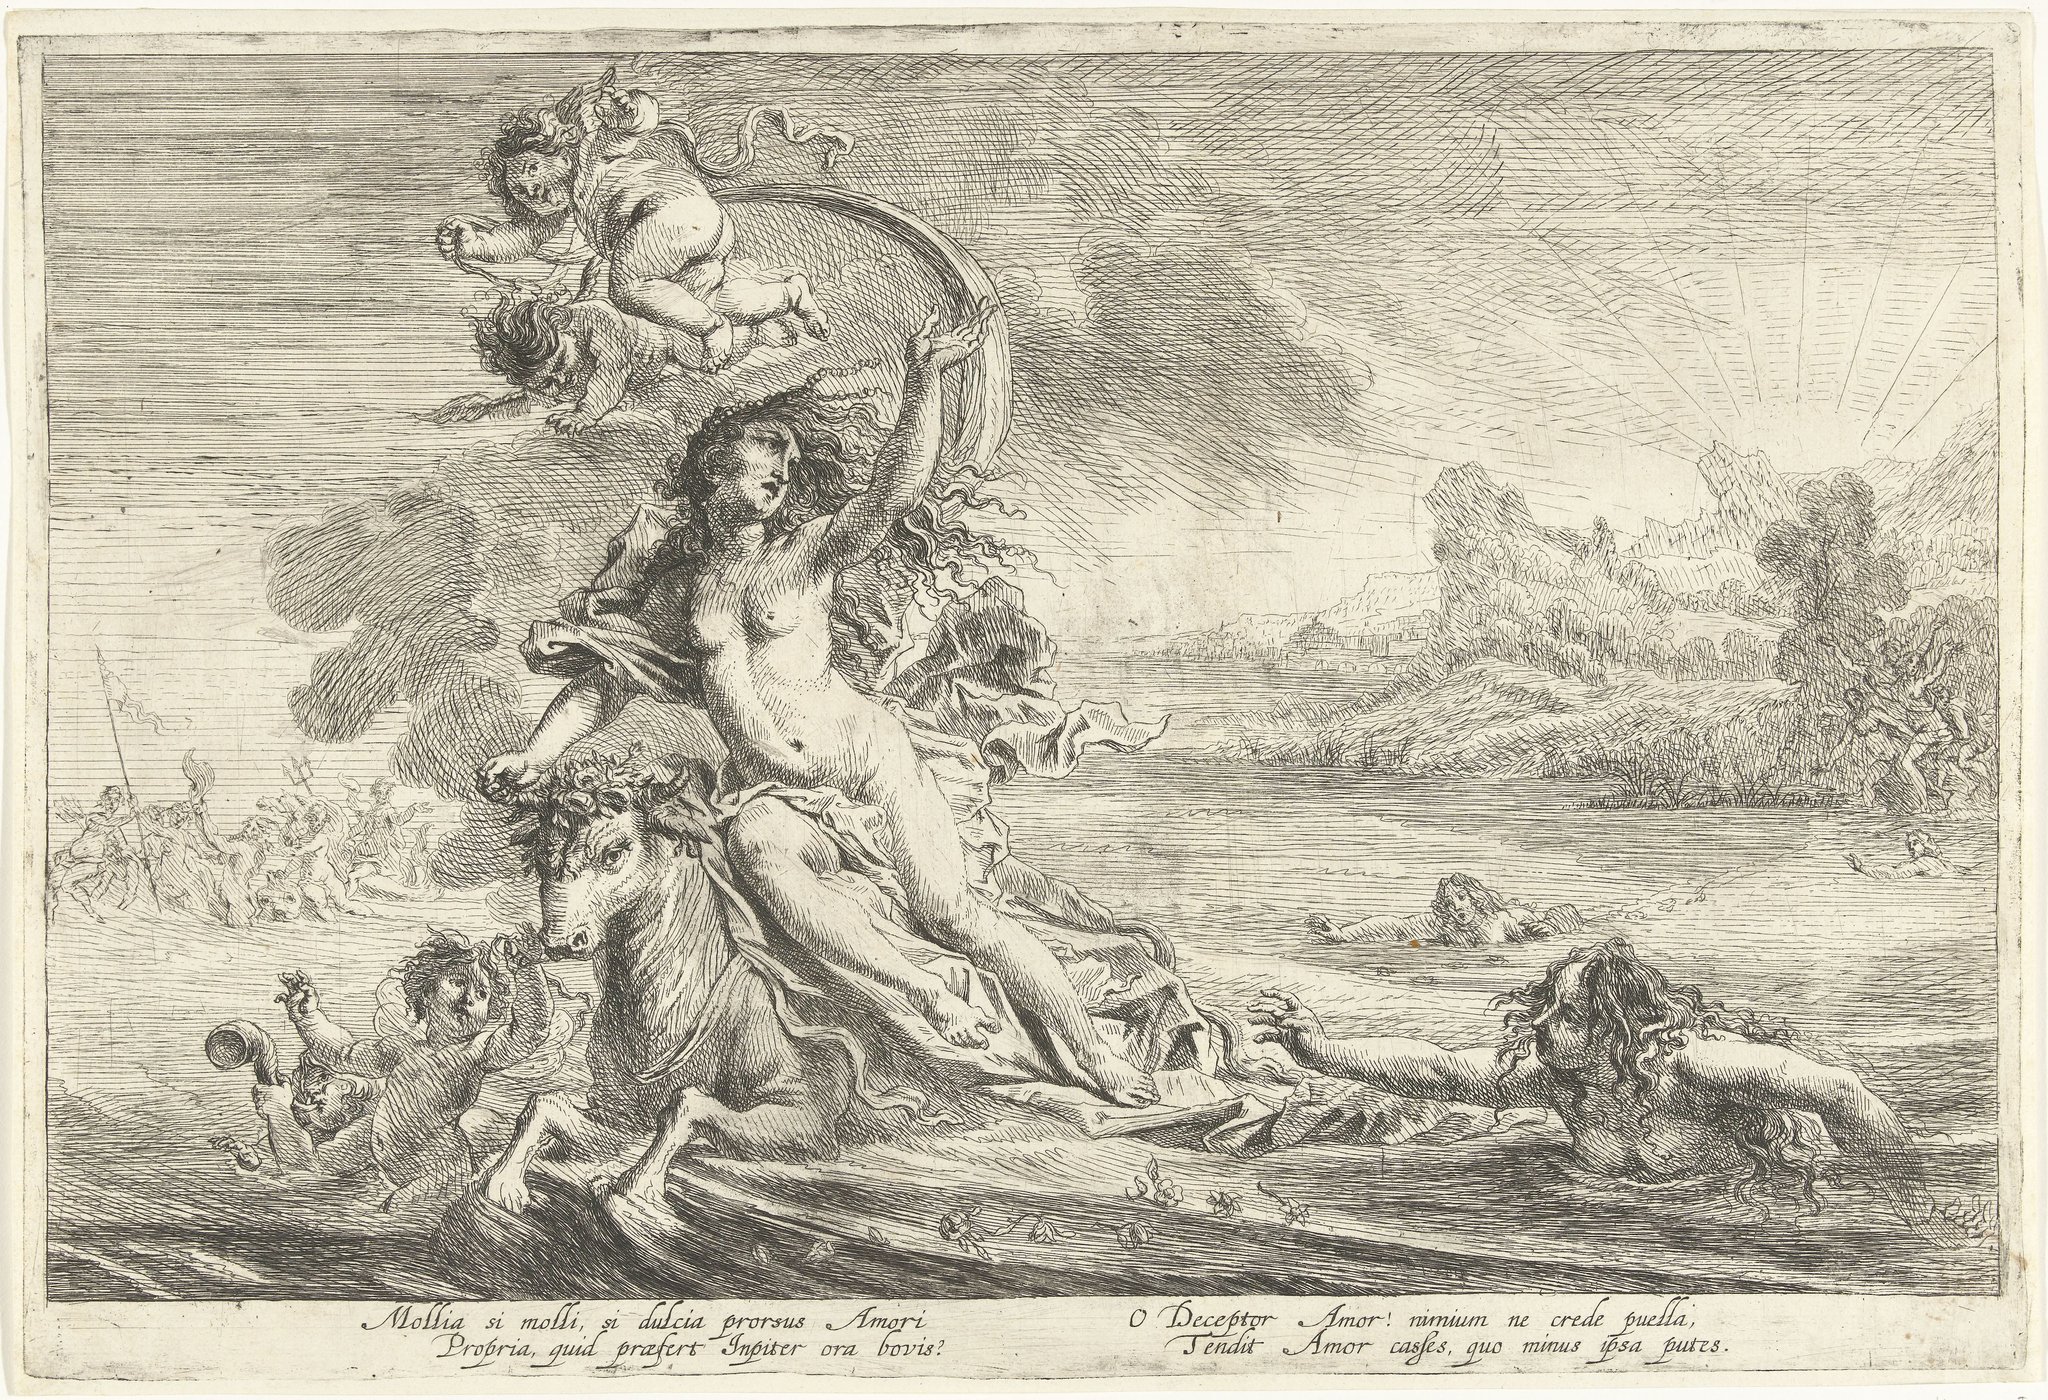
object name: print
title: De roof van Europa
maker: remoldus eynhoudts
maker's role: print maker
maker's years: 1613-1680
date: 1626-1680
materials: paper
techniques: etching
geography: antwerp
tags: jupiter, usually in the shape of a white bull, abducts europa and carries her across the water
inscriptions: collector's mark: Lugt 240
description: Jupiter, in de gedaante van een stier, ontvoert Europa op zijn rug door de zee. In het water en op het strand op de achtergrond Europa`s wanhopige dienstmaagden. Onder de voorstelling een opschrift in Latijn.